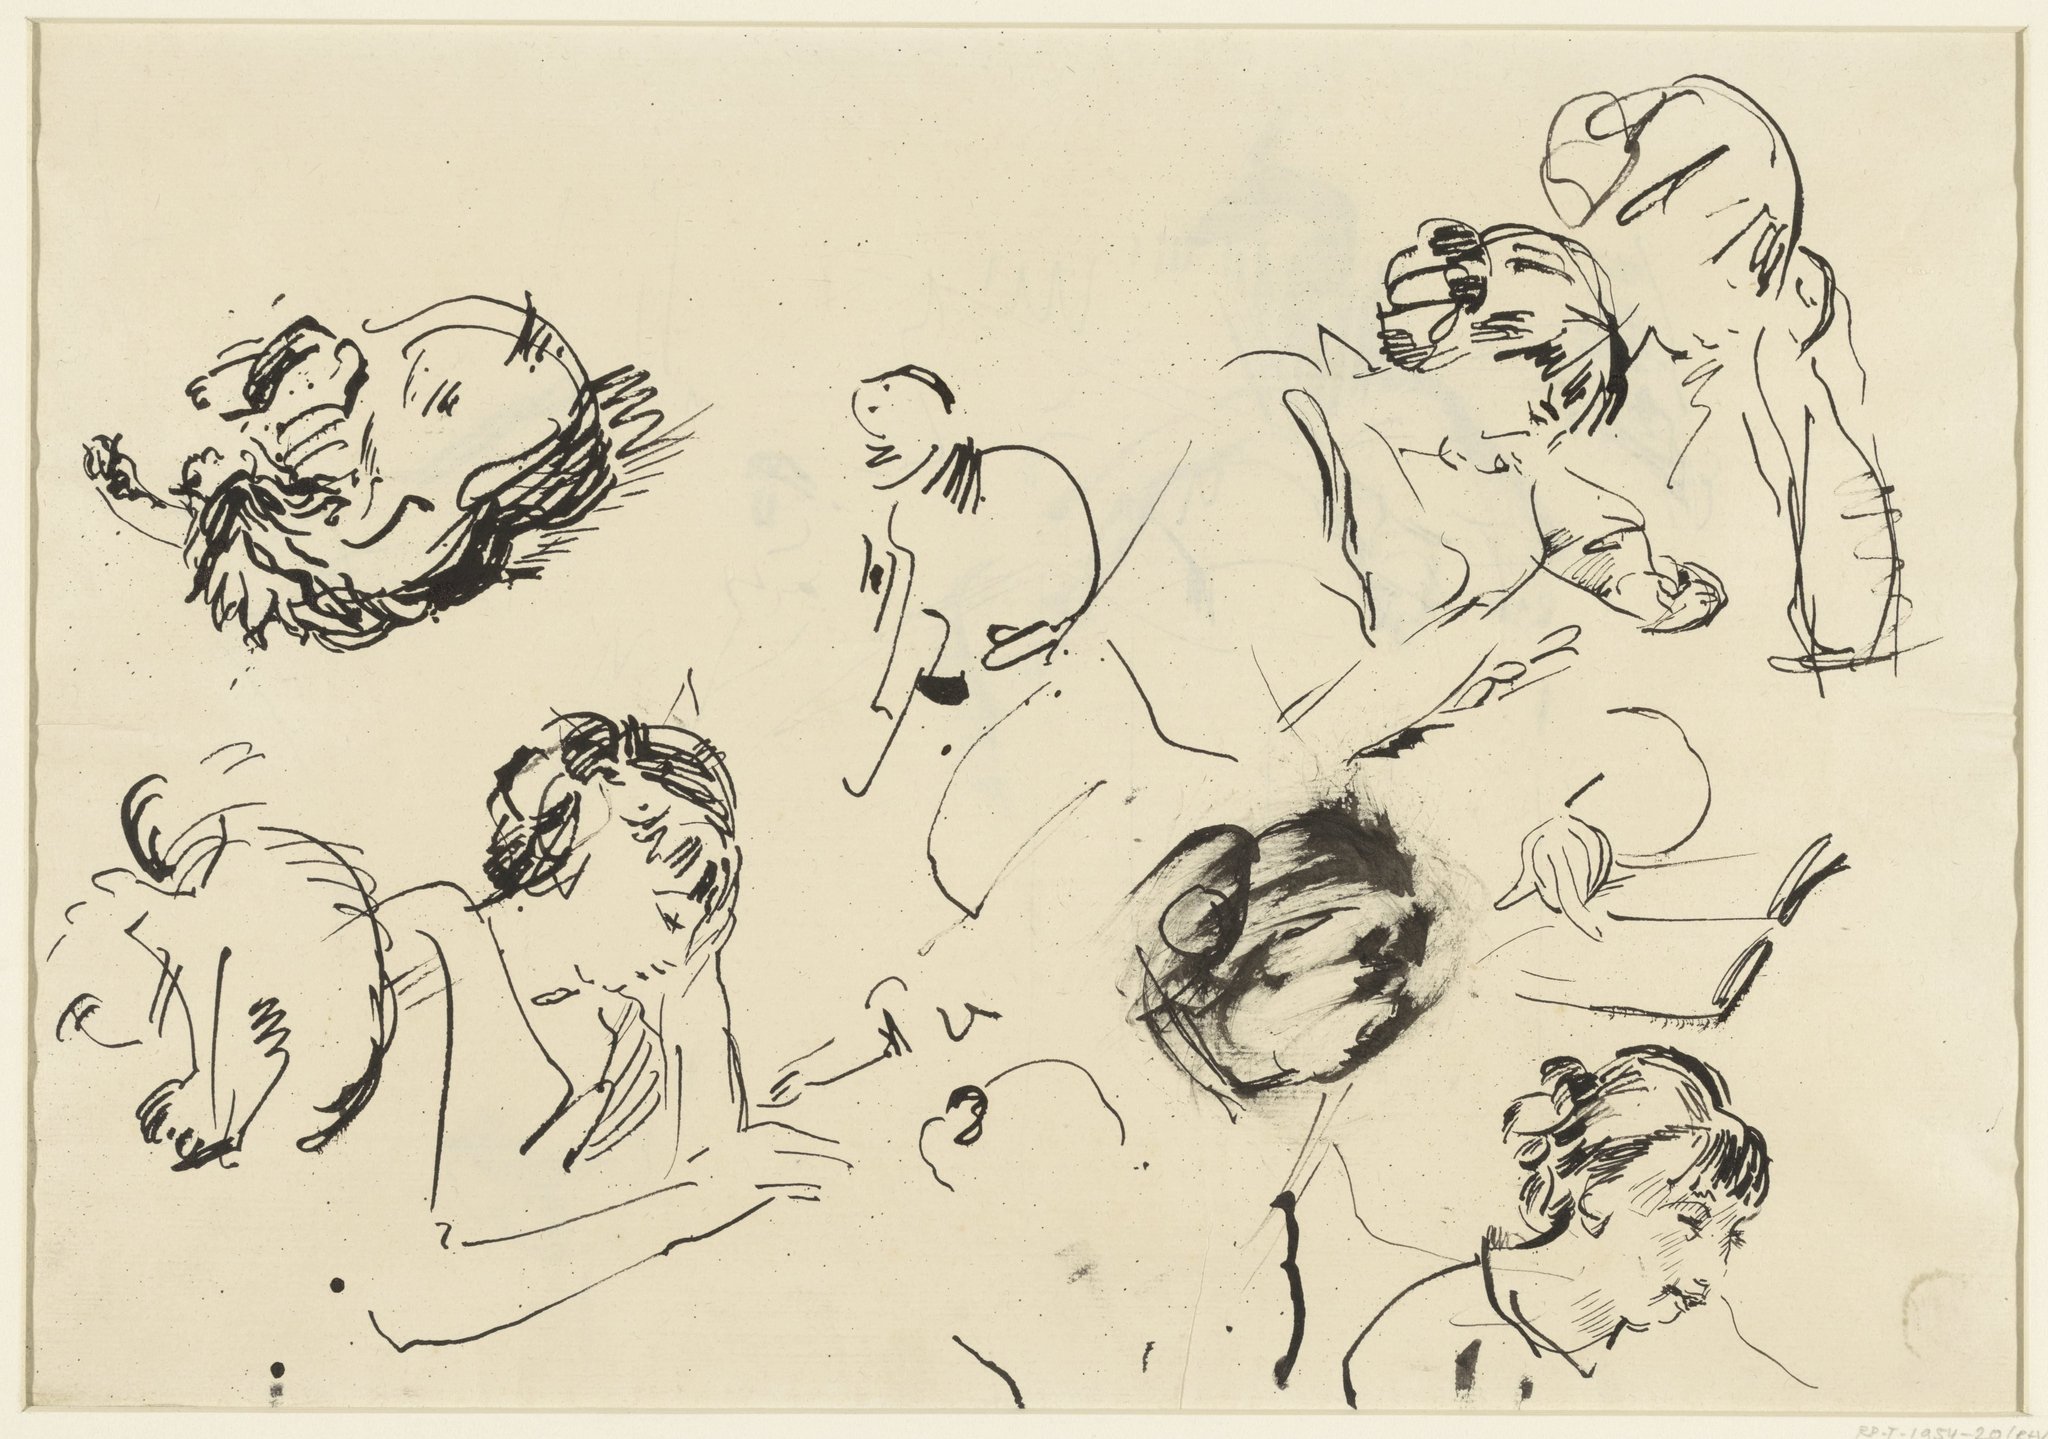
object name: drawing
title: Studies van een lezende vrouw en spelende kat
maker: rik wouters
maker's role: draughtsman, print maker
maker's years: 1882-1916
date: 1892-1916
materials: ink, paper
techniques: pen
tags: reading, cat